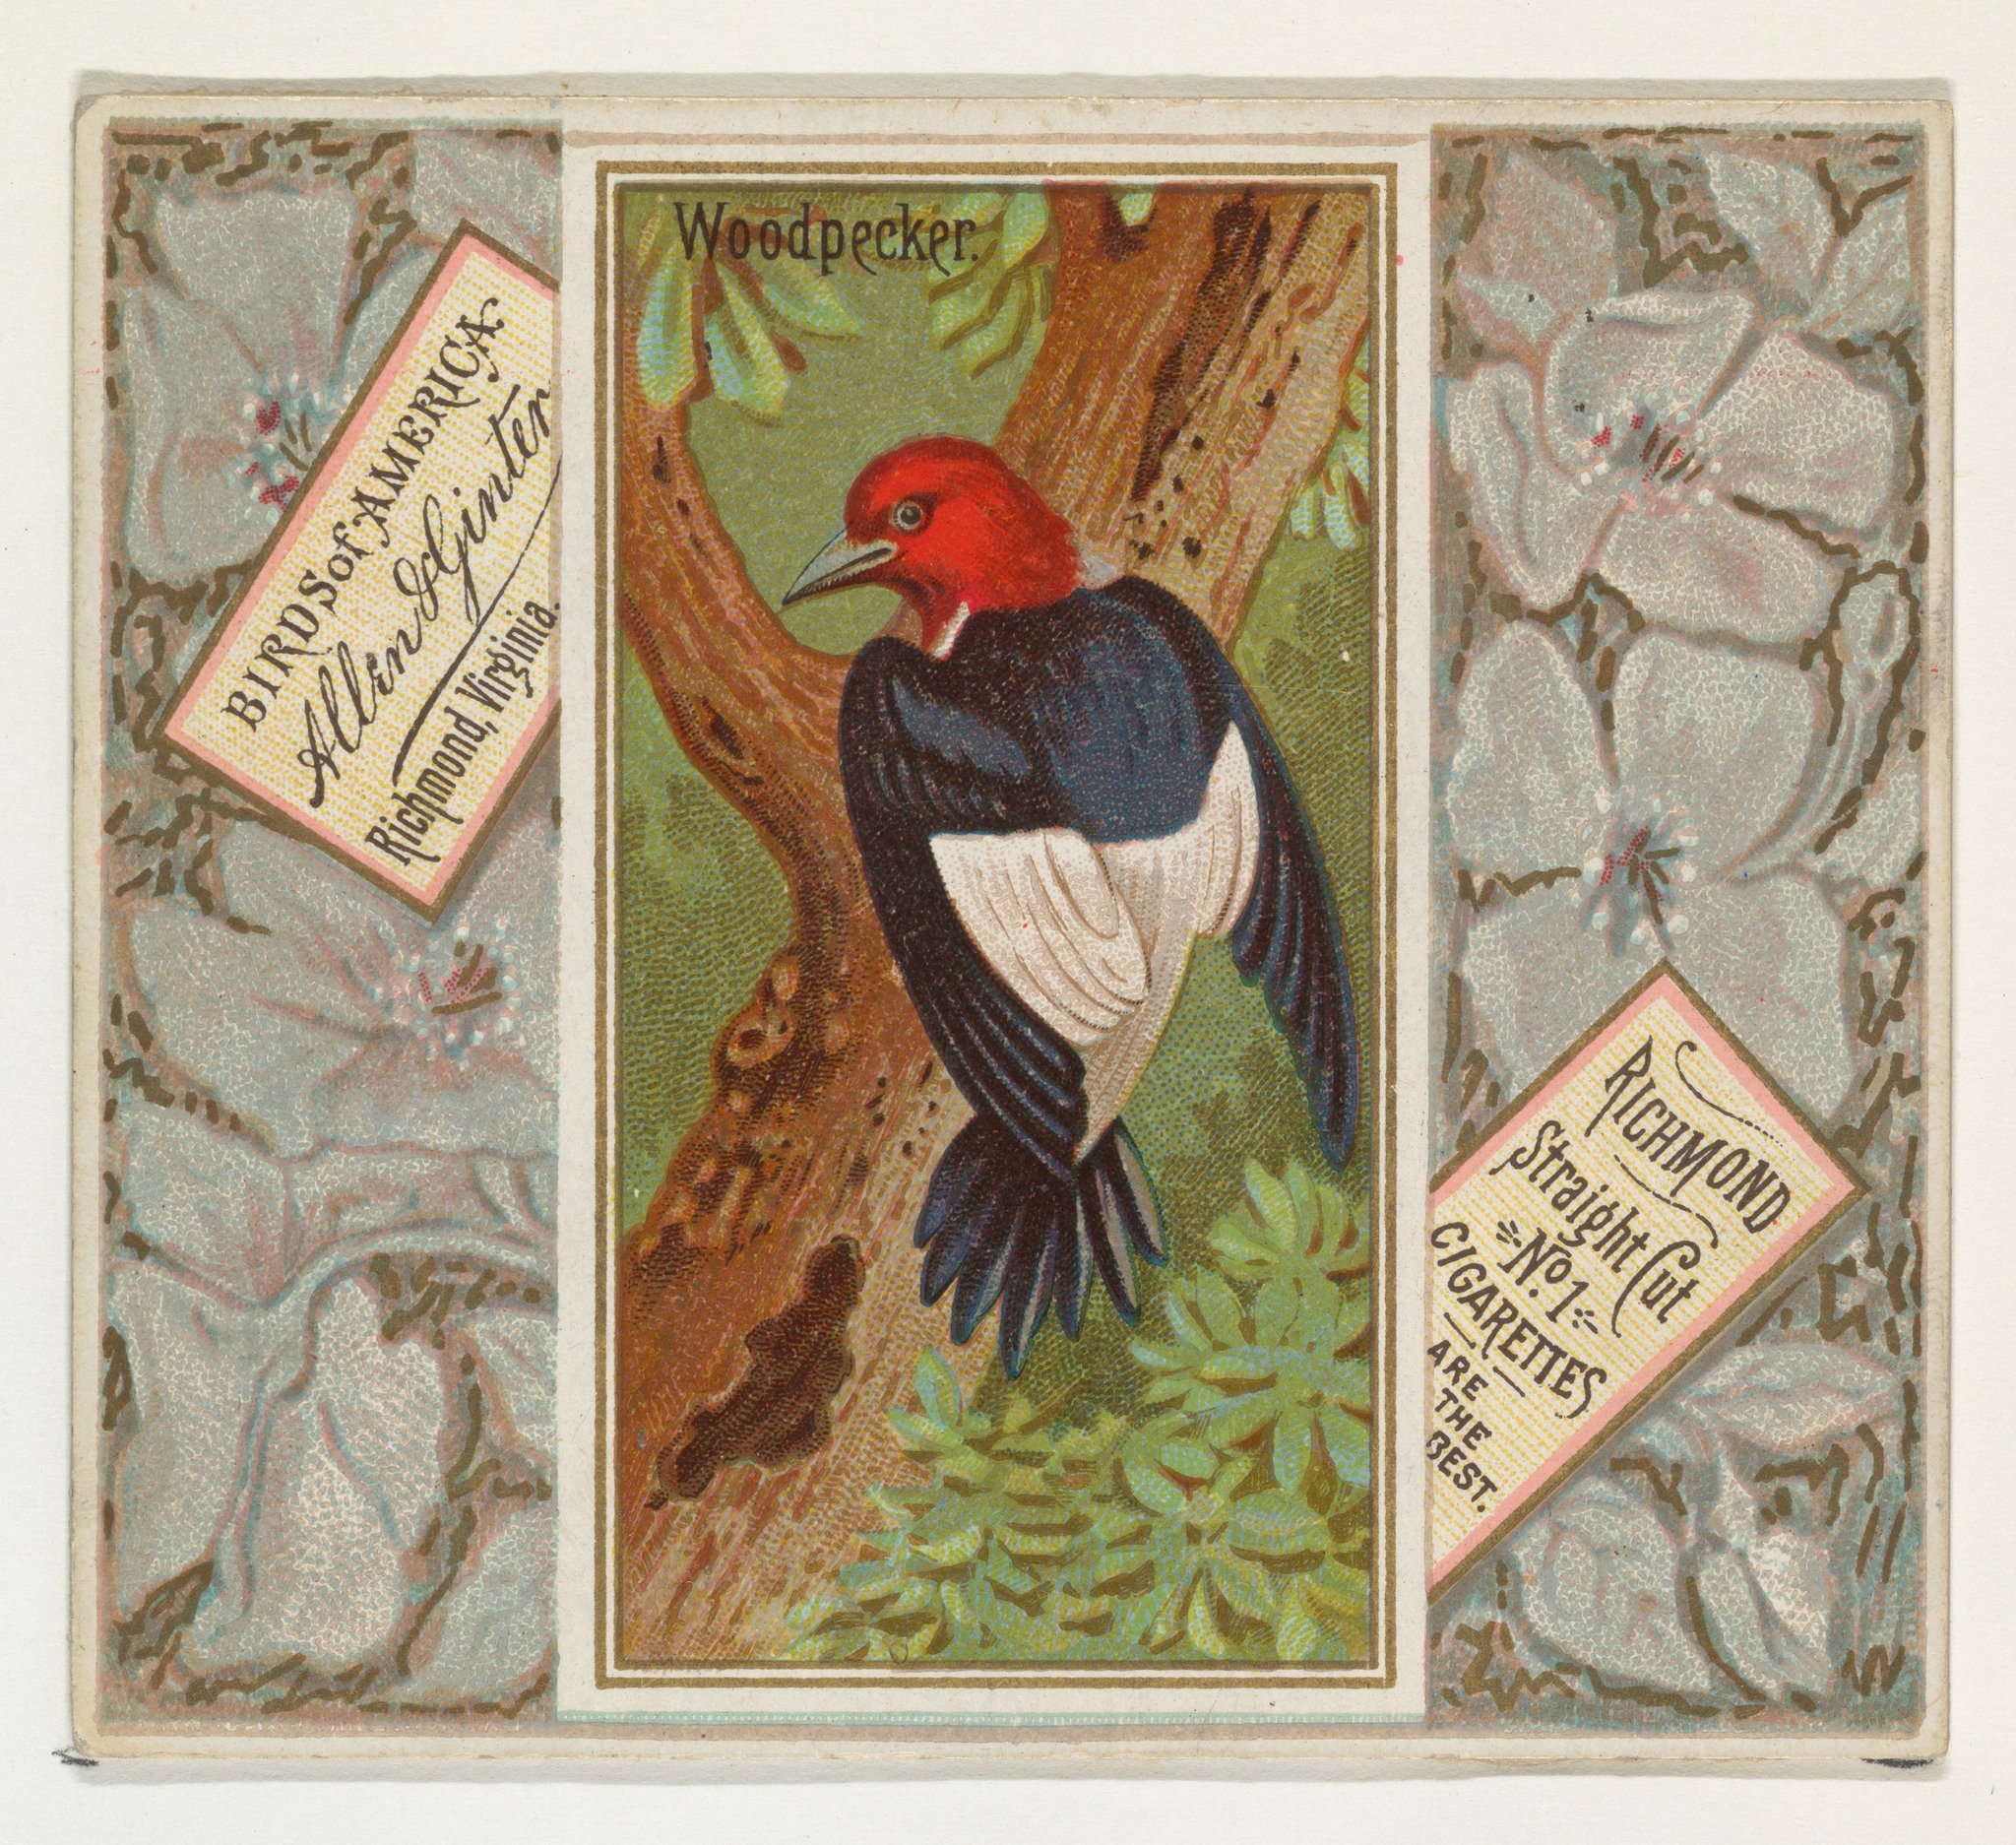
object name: print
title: Woodpecker, from the Birds of America series (N37) for Allen & Ginter Cigarettes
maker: allen & ginter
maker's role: publisher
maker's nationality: american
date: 1888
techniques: color lithograph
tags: birds